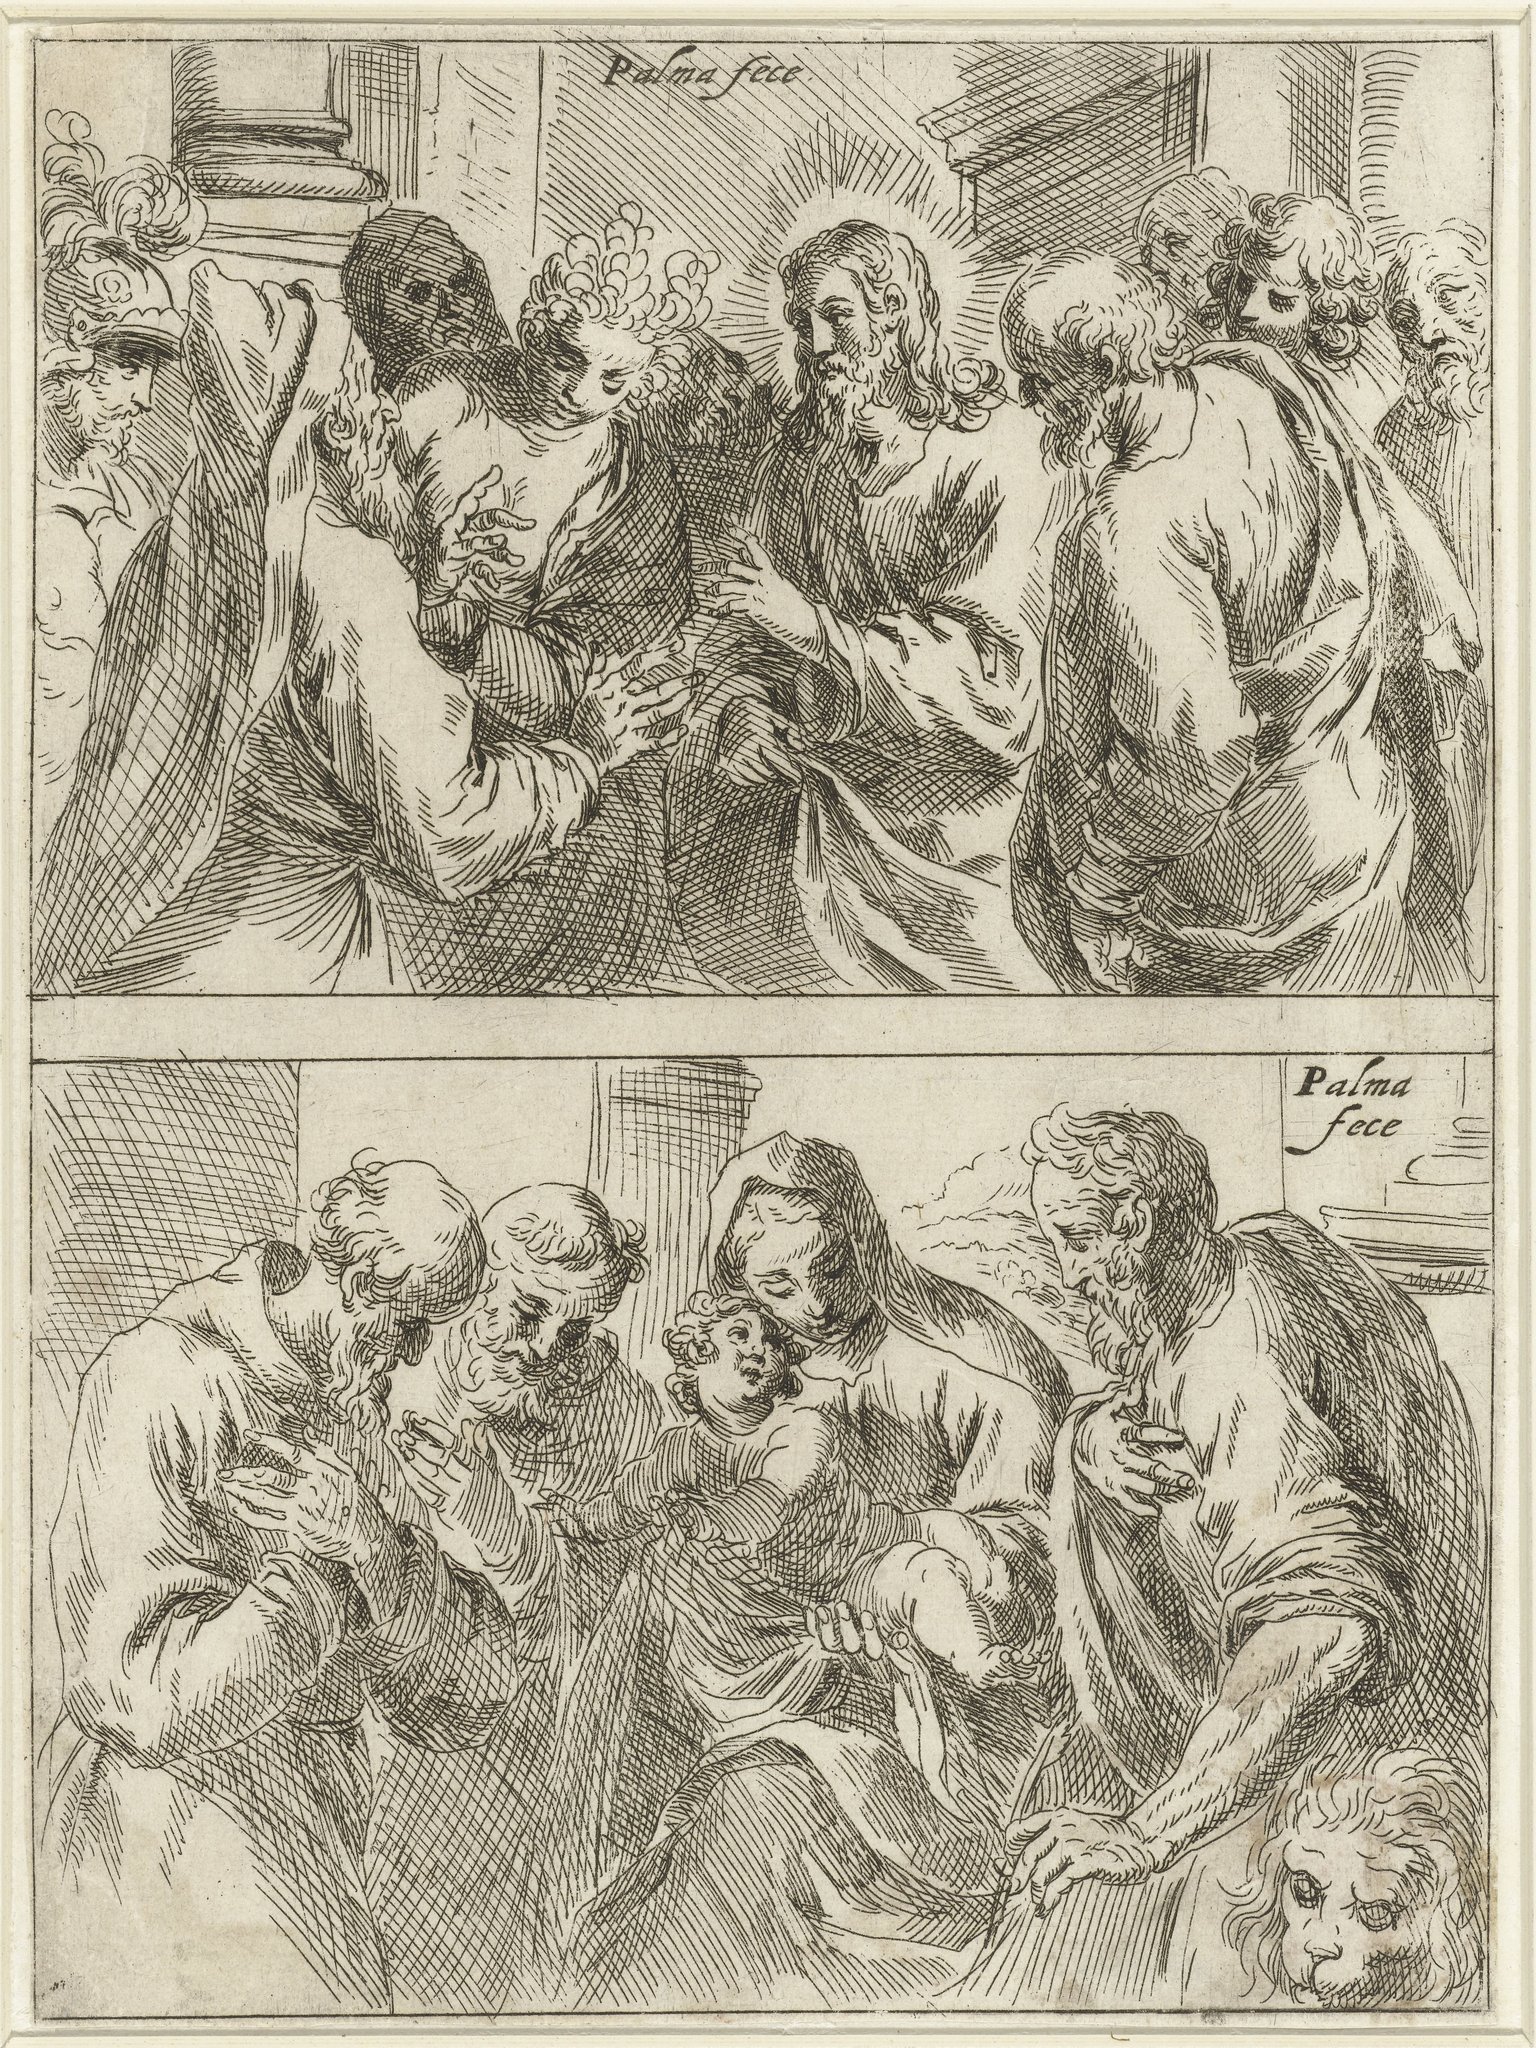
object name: print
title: Maria met kind en Christus met de overspelige vrouw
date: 1554-1611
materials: paper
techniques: etching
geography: italy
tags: pharisees bring a woman accused of adultery before christ (john 8:2-11), holy family, and derived representations, founder of the order of friars minor (franciscans), francis(cus) of assisi; possible attributes: book, crucifix, lily, skull, stigmata, the monk and hermit jerome (hieronymus); possible attributes: book, cardinal's hat, crucifix, hour-glass, lion, skull, stone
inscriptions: collector's mark: Lugt 240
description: Twee voorstellingen op één blad, gedrukt van één plaat. Boven: Christus en de overspelige vrouw, omringd door Farizeeërs in de tempel. Onder: Maria met het Christuskind in haar armen, omringd door Jozef, de heilige Franciscus met de stigmata en de heilige Hieronymus met de leeuw.